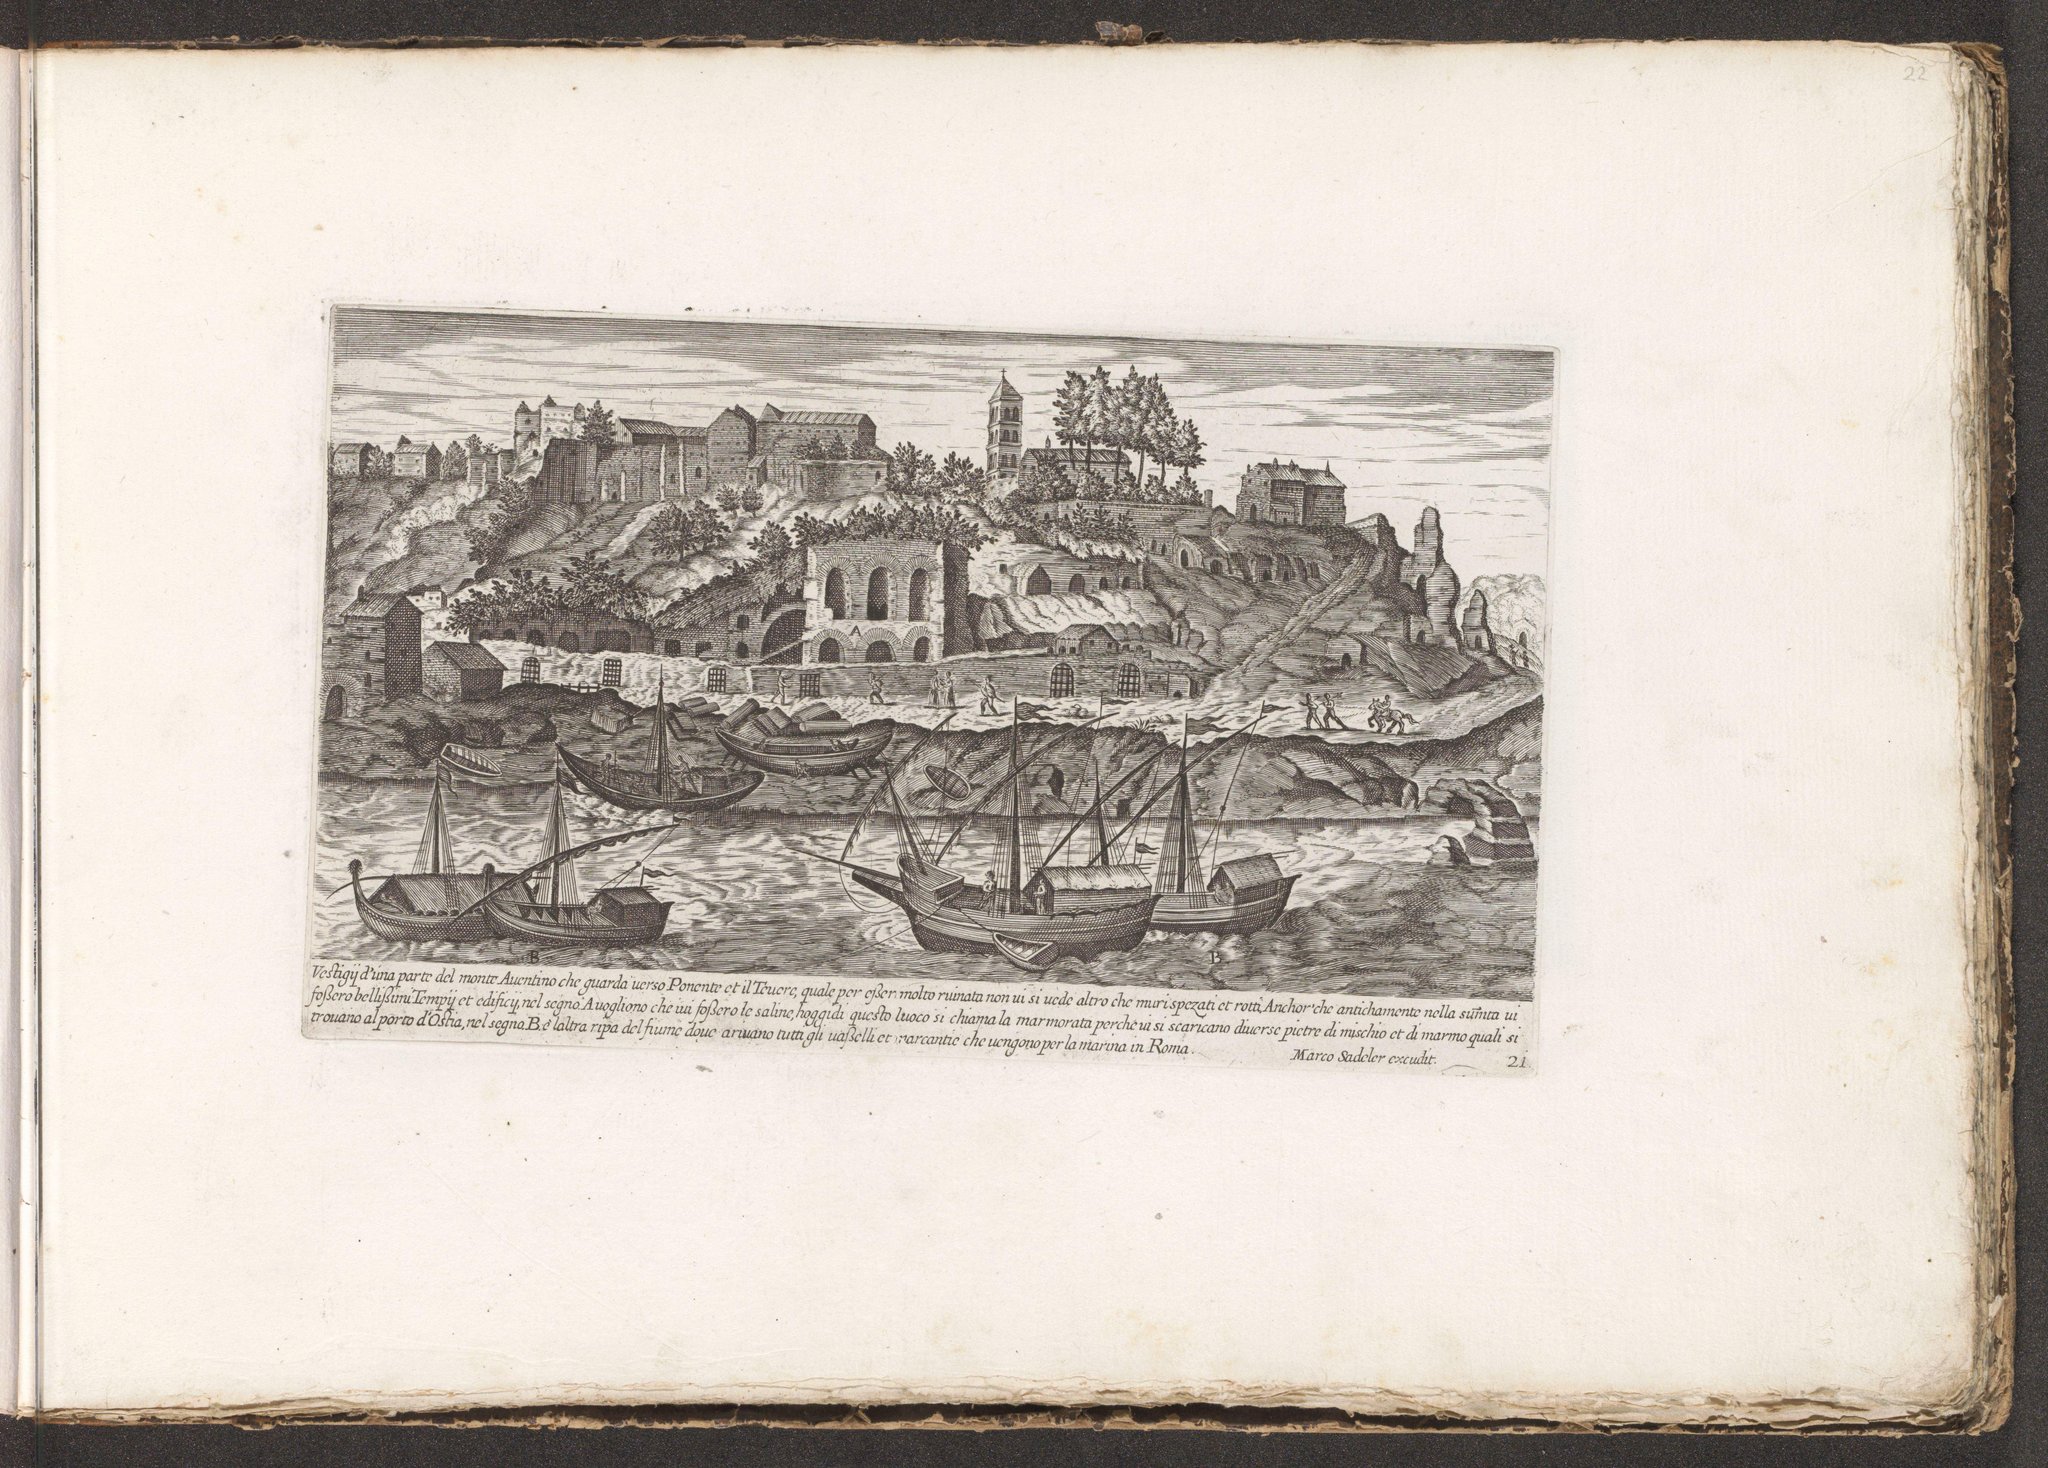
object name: album leaf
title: Ruïnes op de Aventijn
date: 1680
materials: paper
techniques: engraving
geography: prague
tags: rome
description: Overblijfselen van de gebouwen op de Aventijn. Op de voorgrond de rivier de Tiber met schepen. In de ondermarge drie regels tekst in het Italiaans. De prent maakt deel uit van een album.